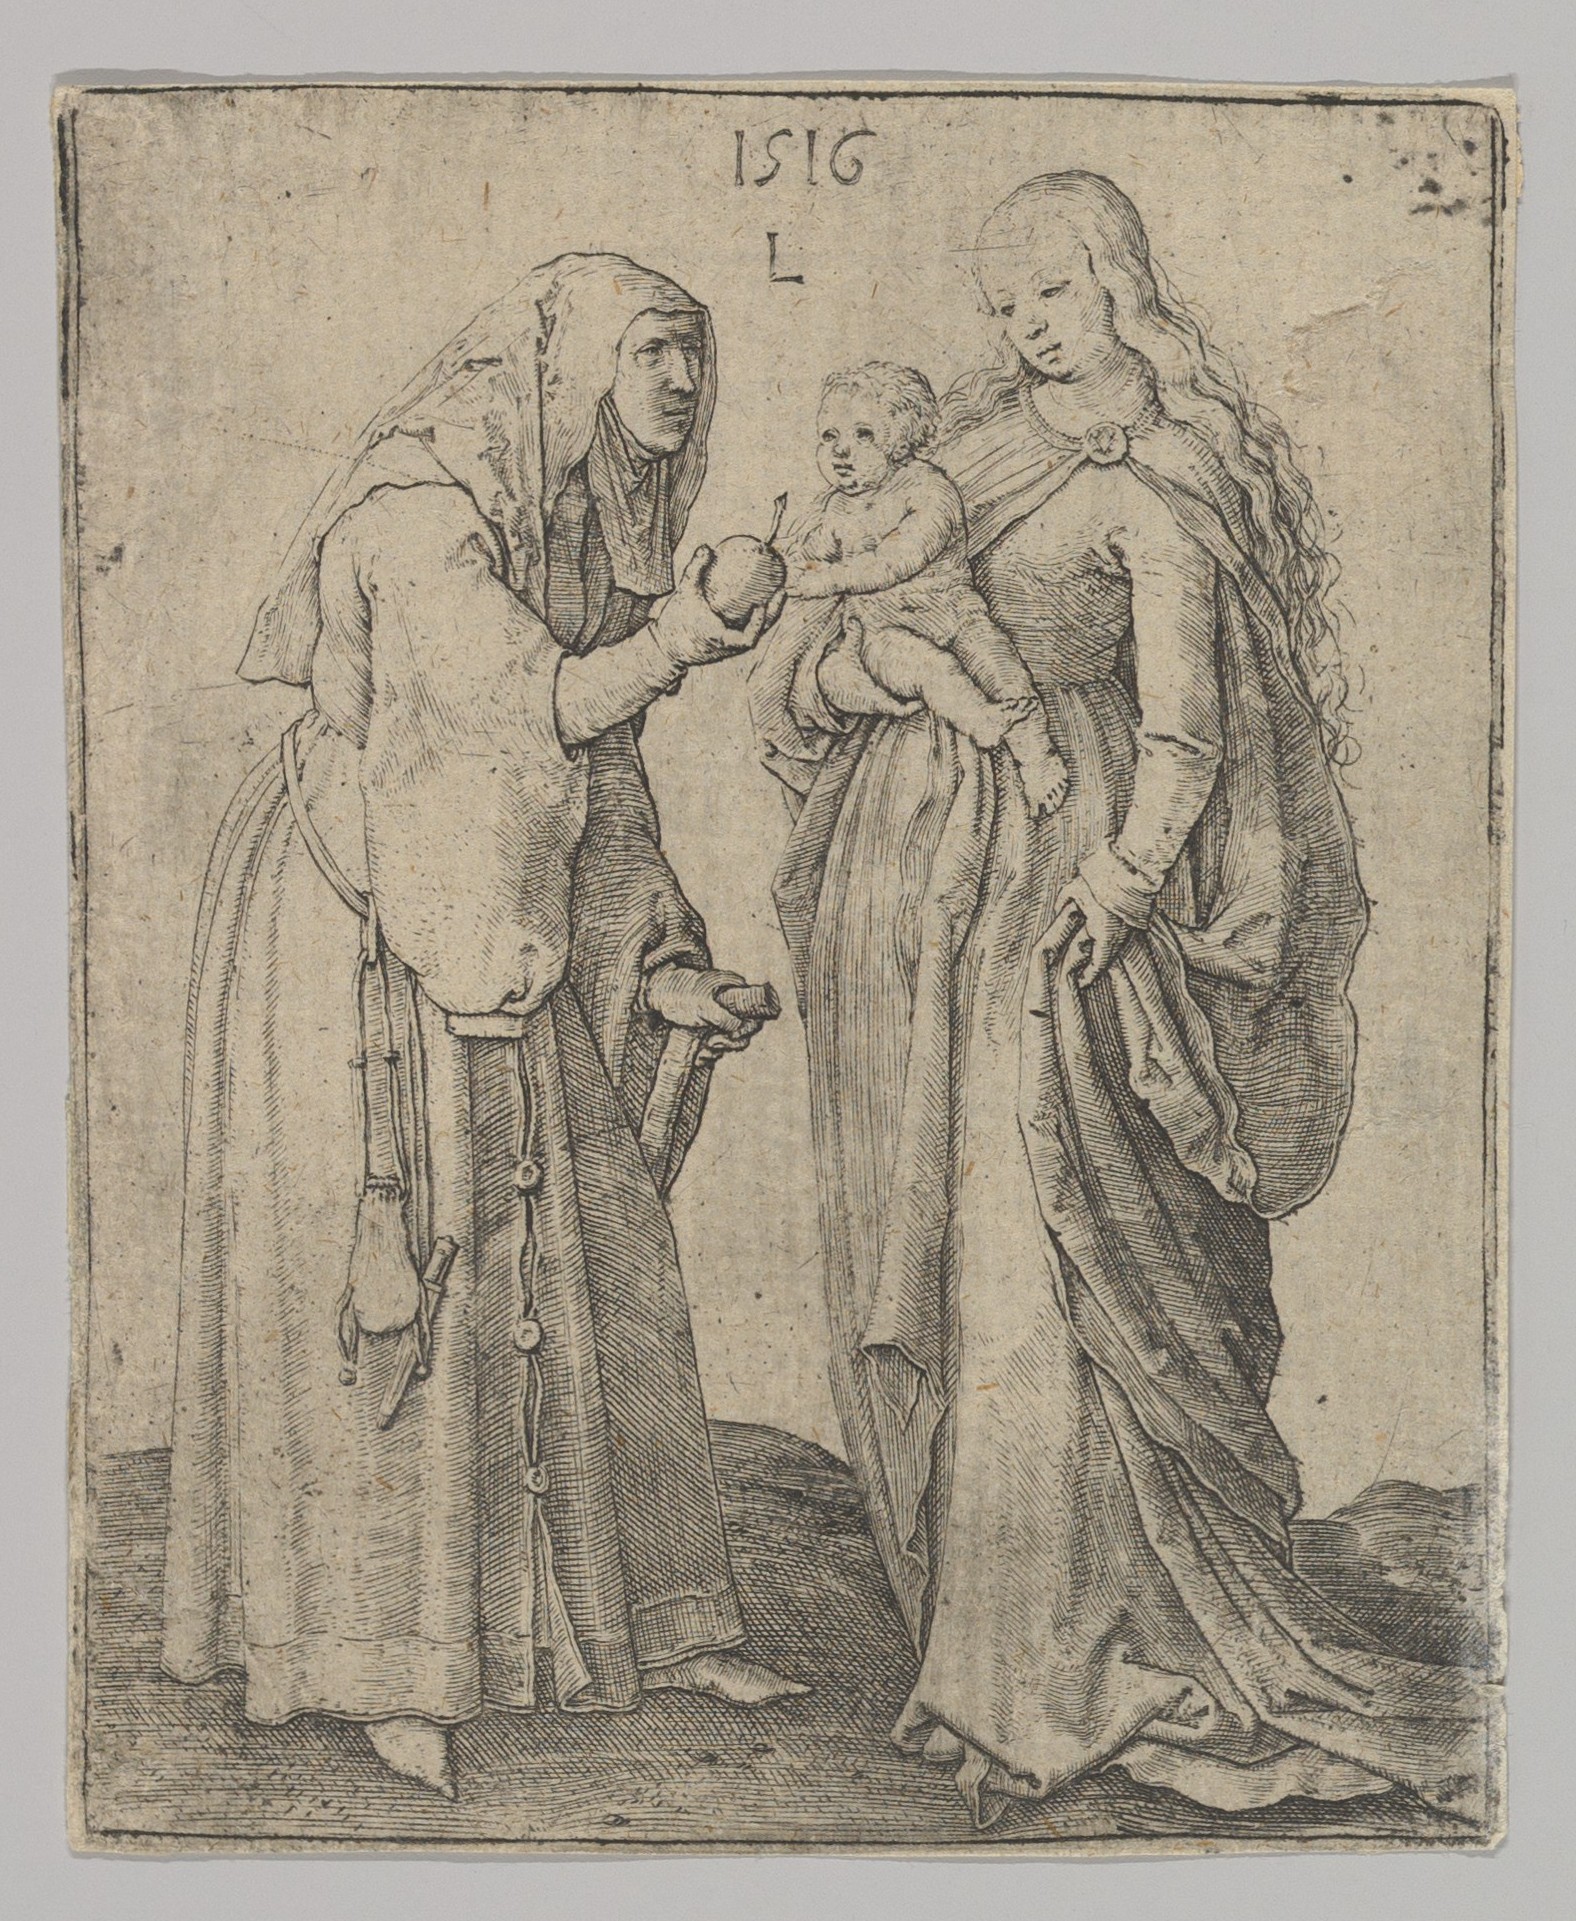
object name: print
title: The Virgin With Child and St. Anna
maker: lucas van leyden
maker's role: artist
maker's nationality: netherlandish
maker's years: 1494-1533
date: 1516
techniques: engraving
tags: saint anne,virgin mary,jesus